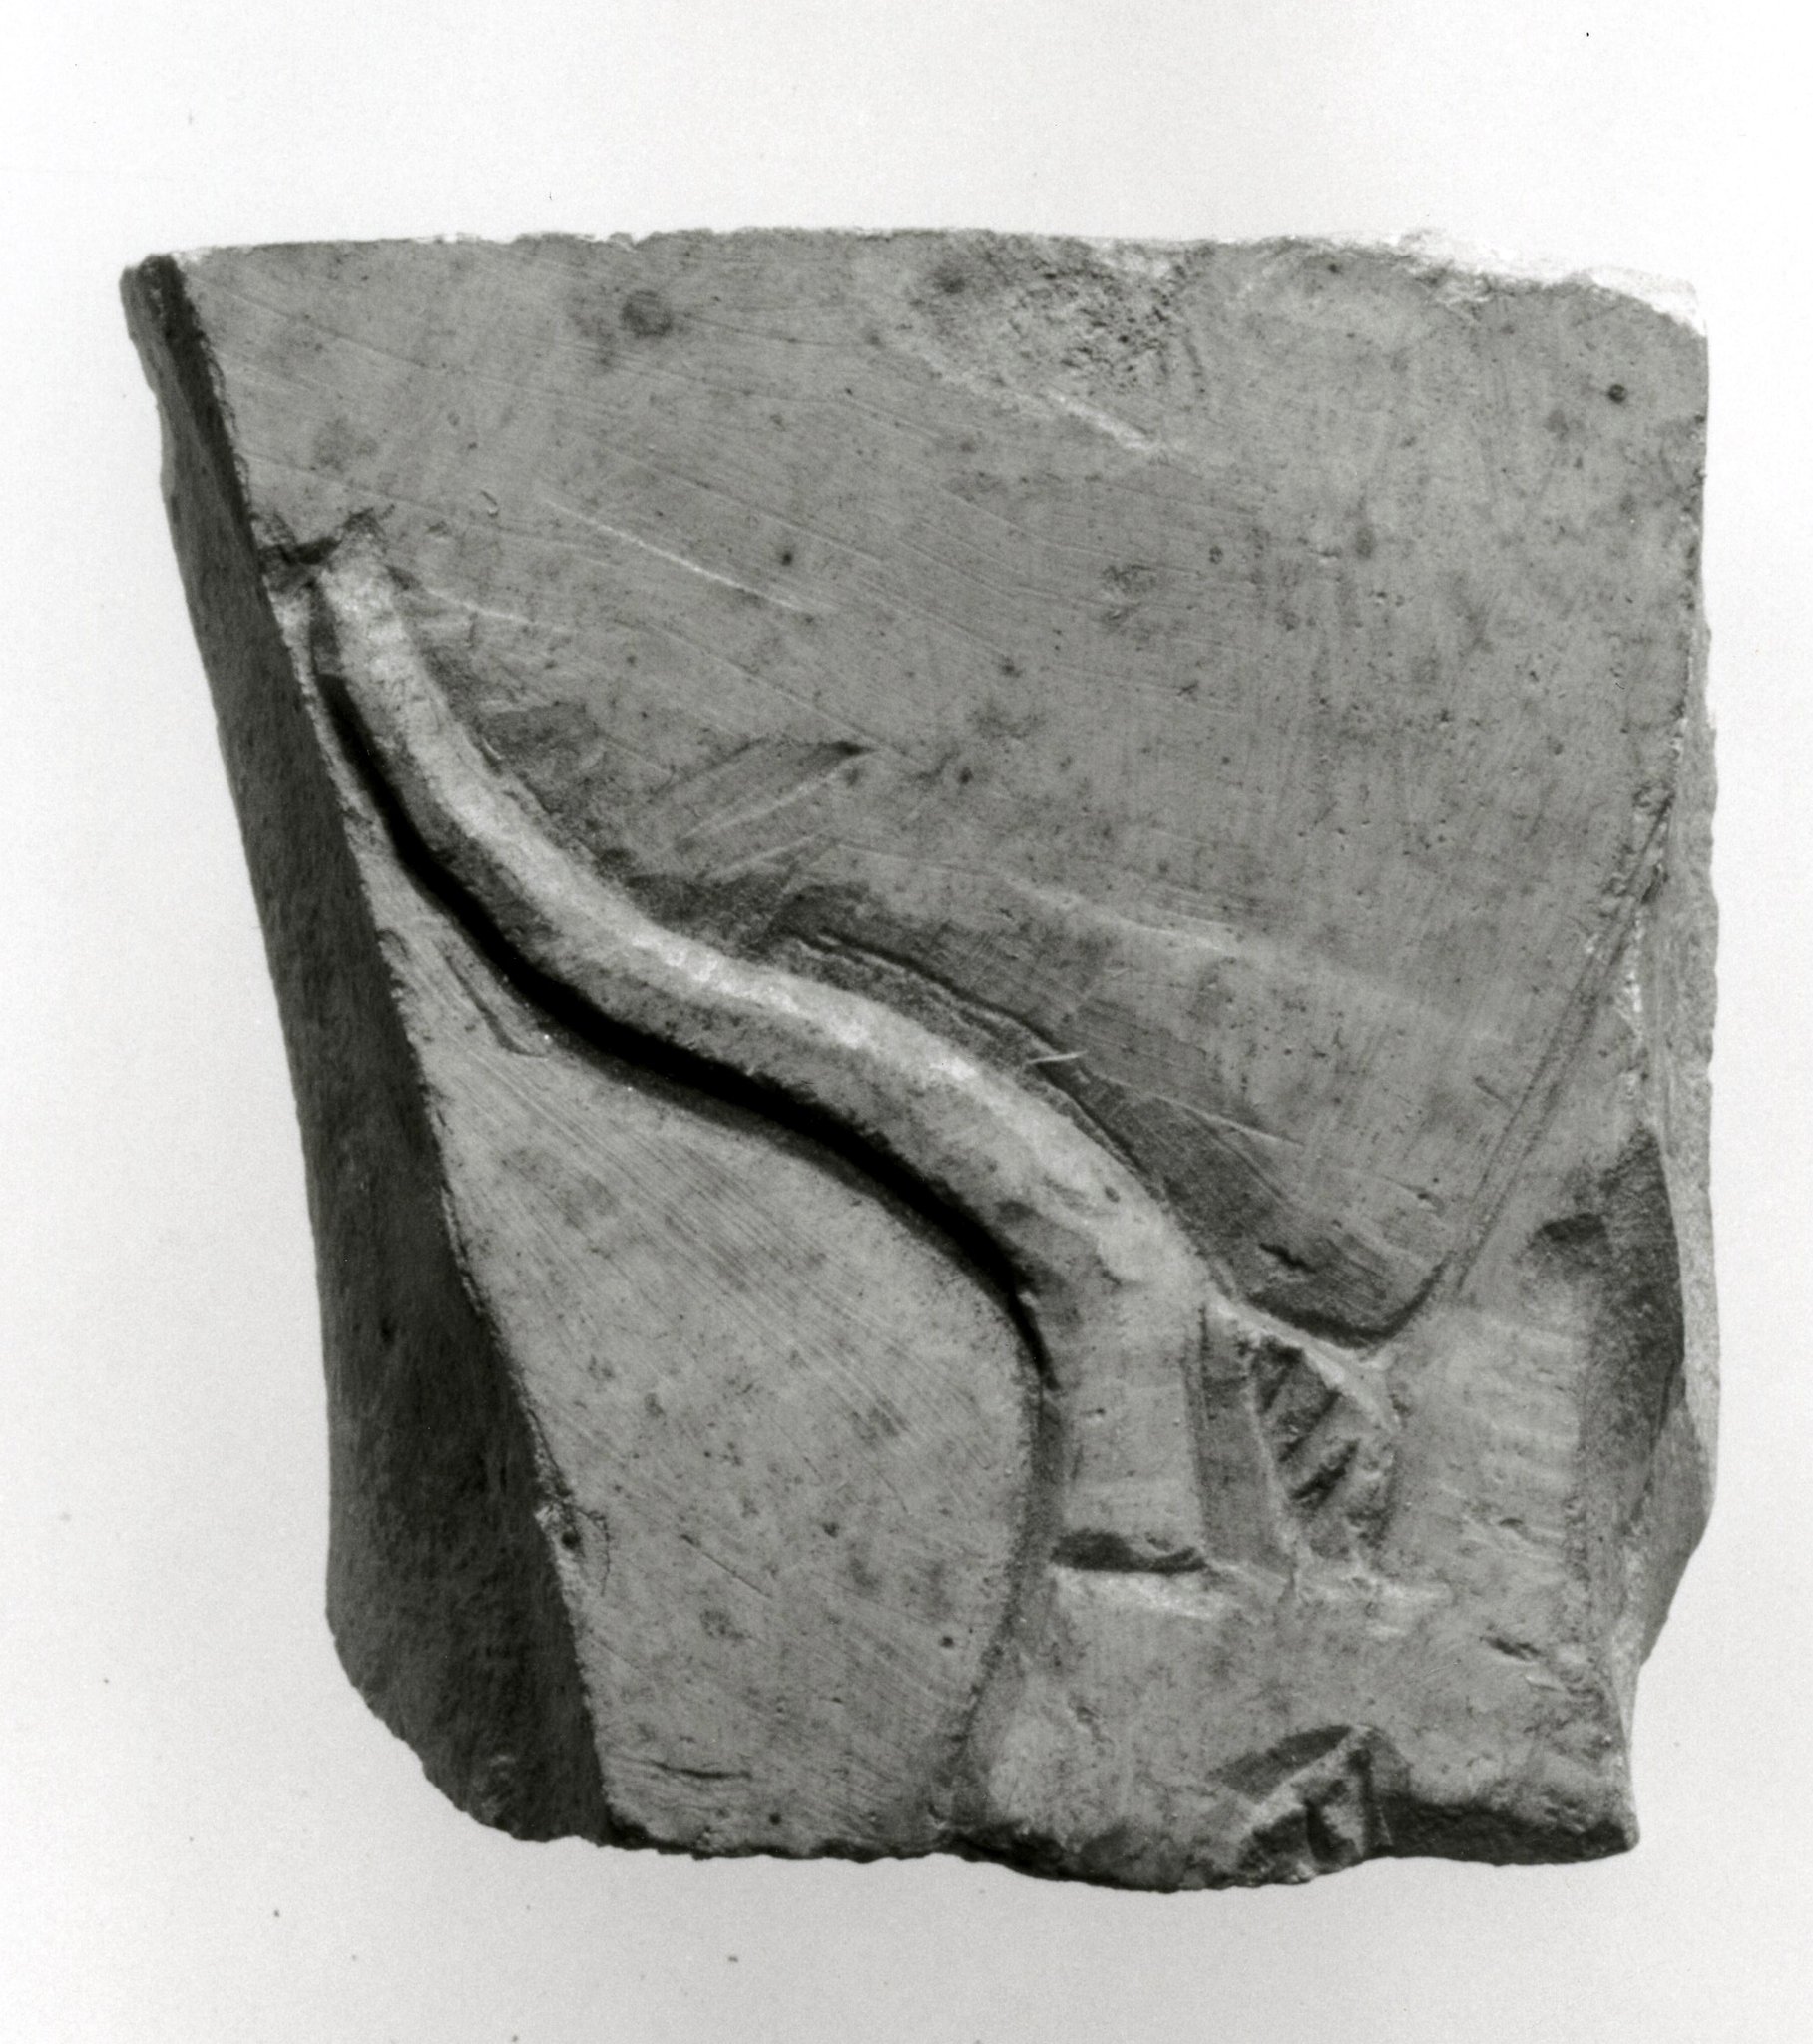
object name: relief, tomb of nespekashuty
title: Raised relief fragment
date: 664-610 BCE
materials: limestone, varnish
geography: egypt